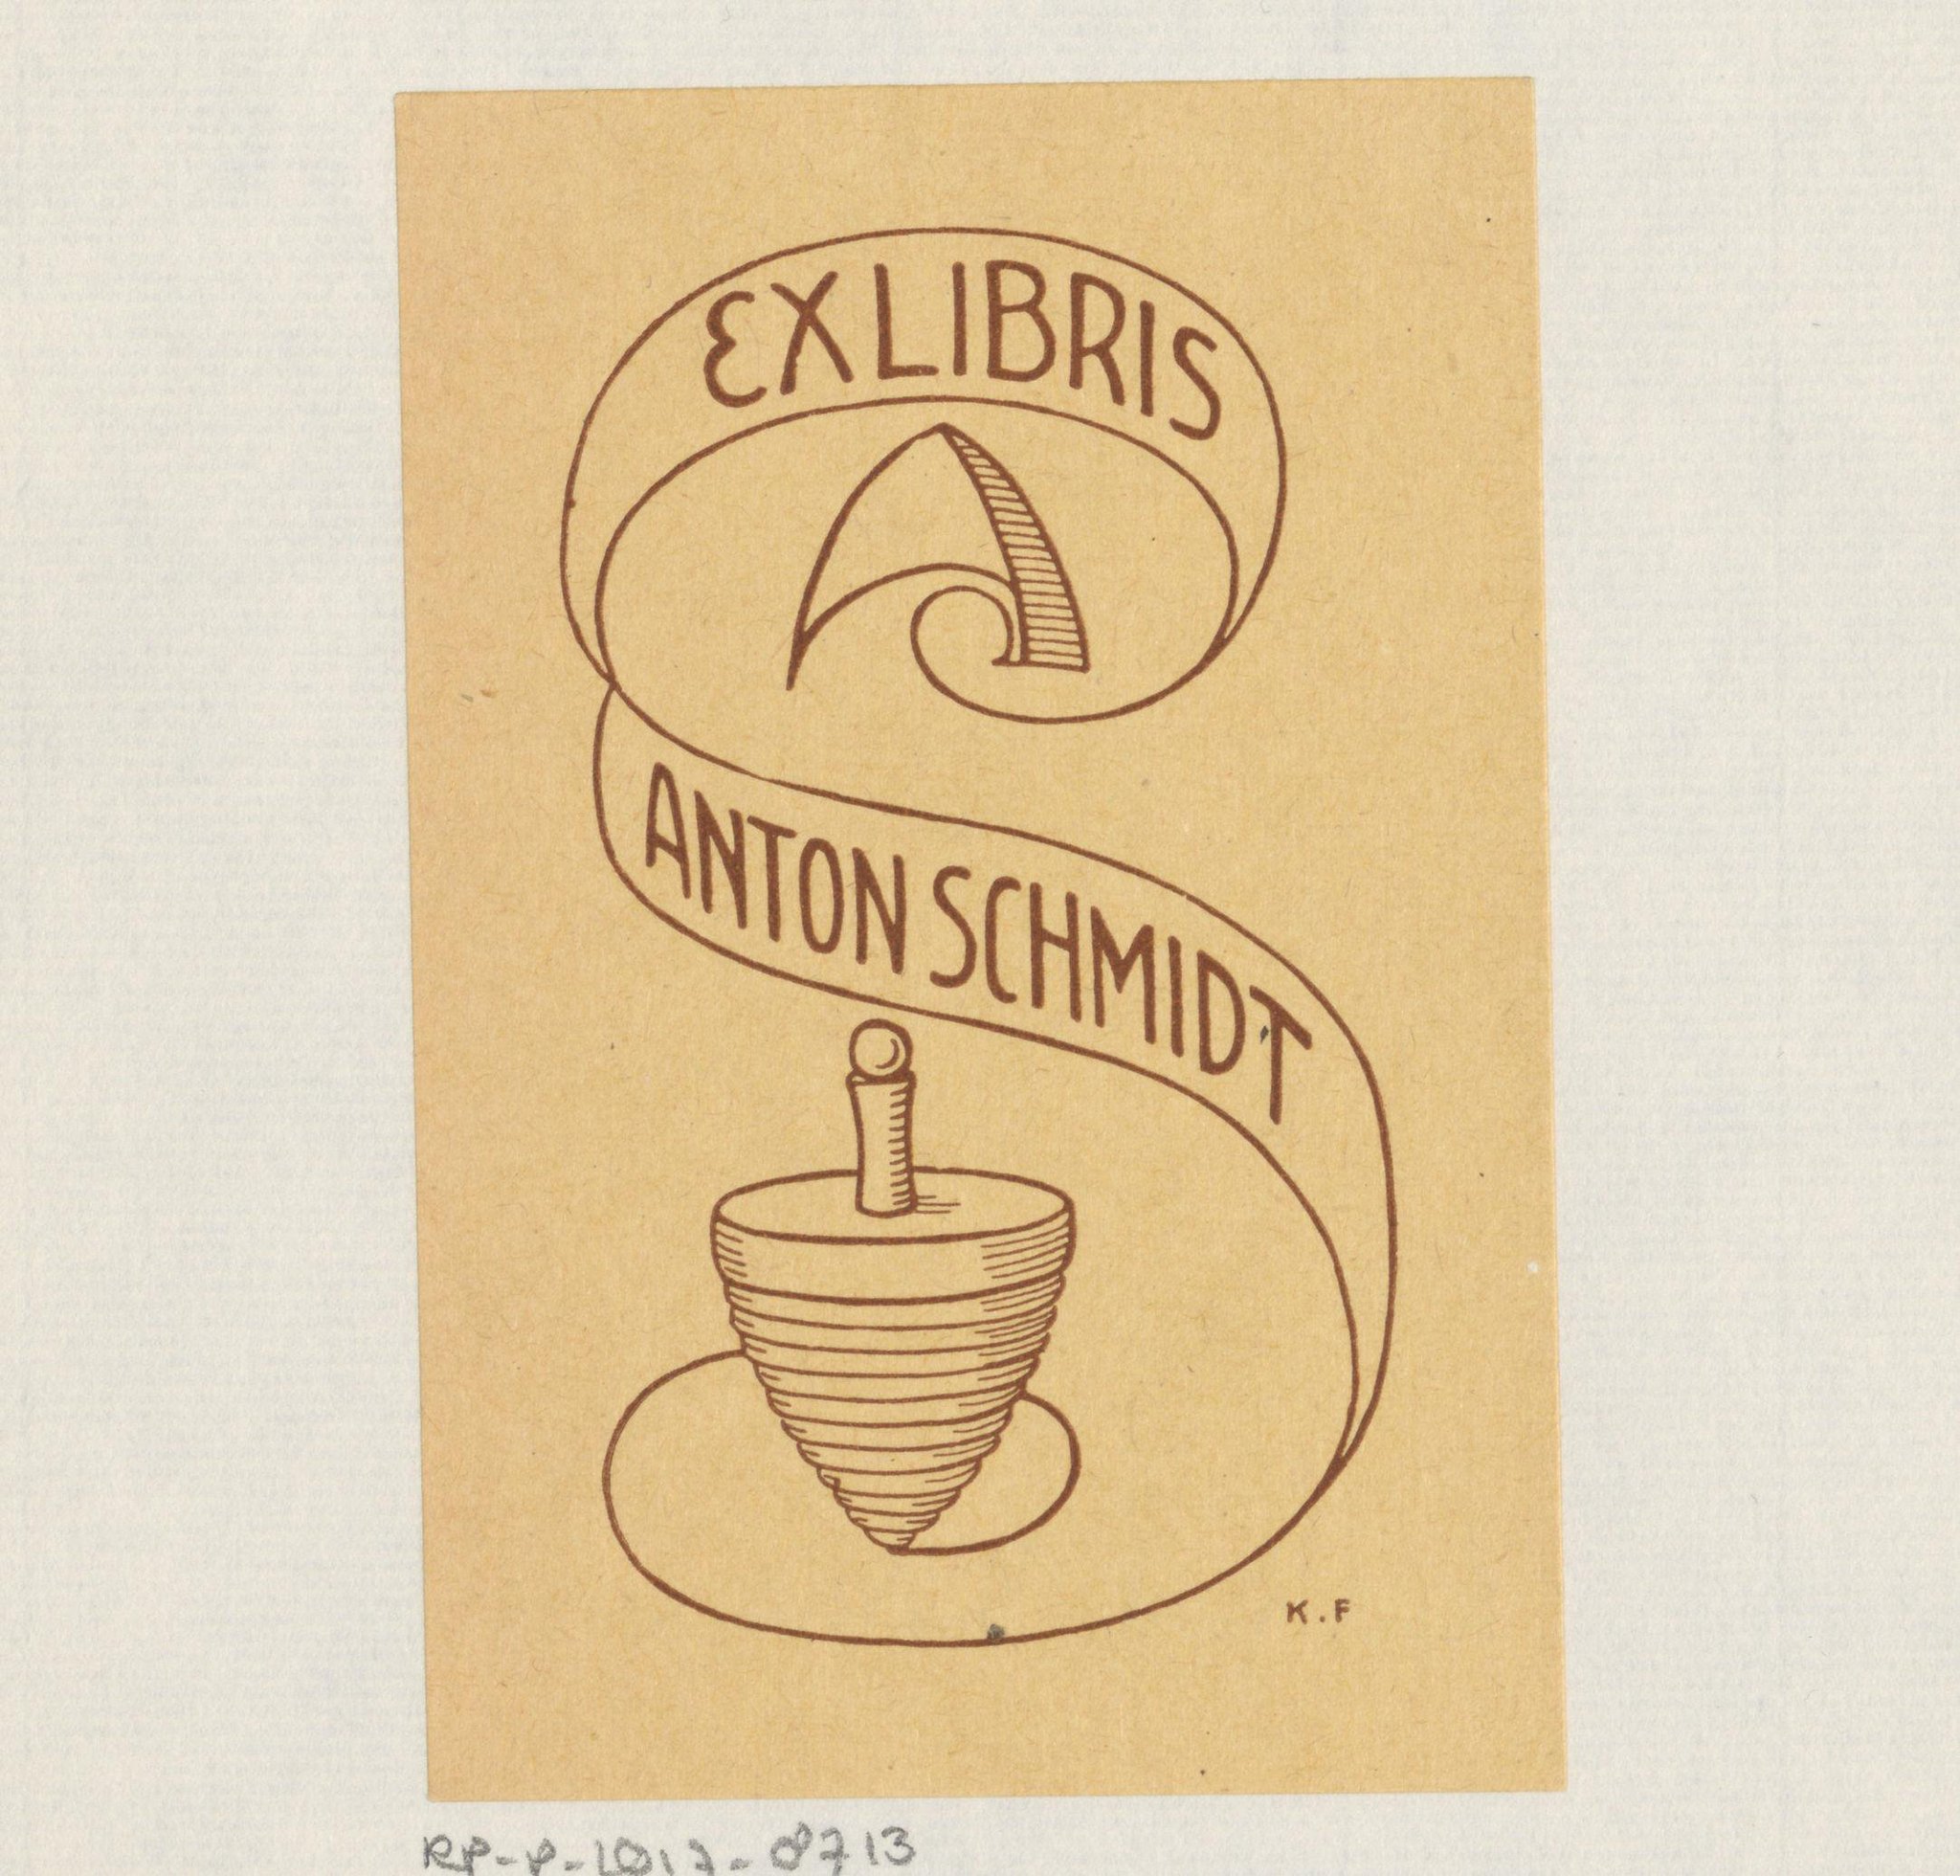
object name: bookplate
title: Ex libris van Anton Schmidt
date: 1942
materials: paper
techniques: printing block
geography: bratislava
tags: (playing with) top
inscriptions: inscription: ‘Cl/ Karl Frech Bratislava 942’